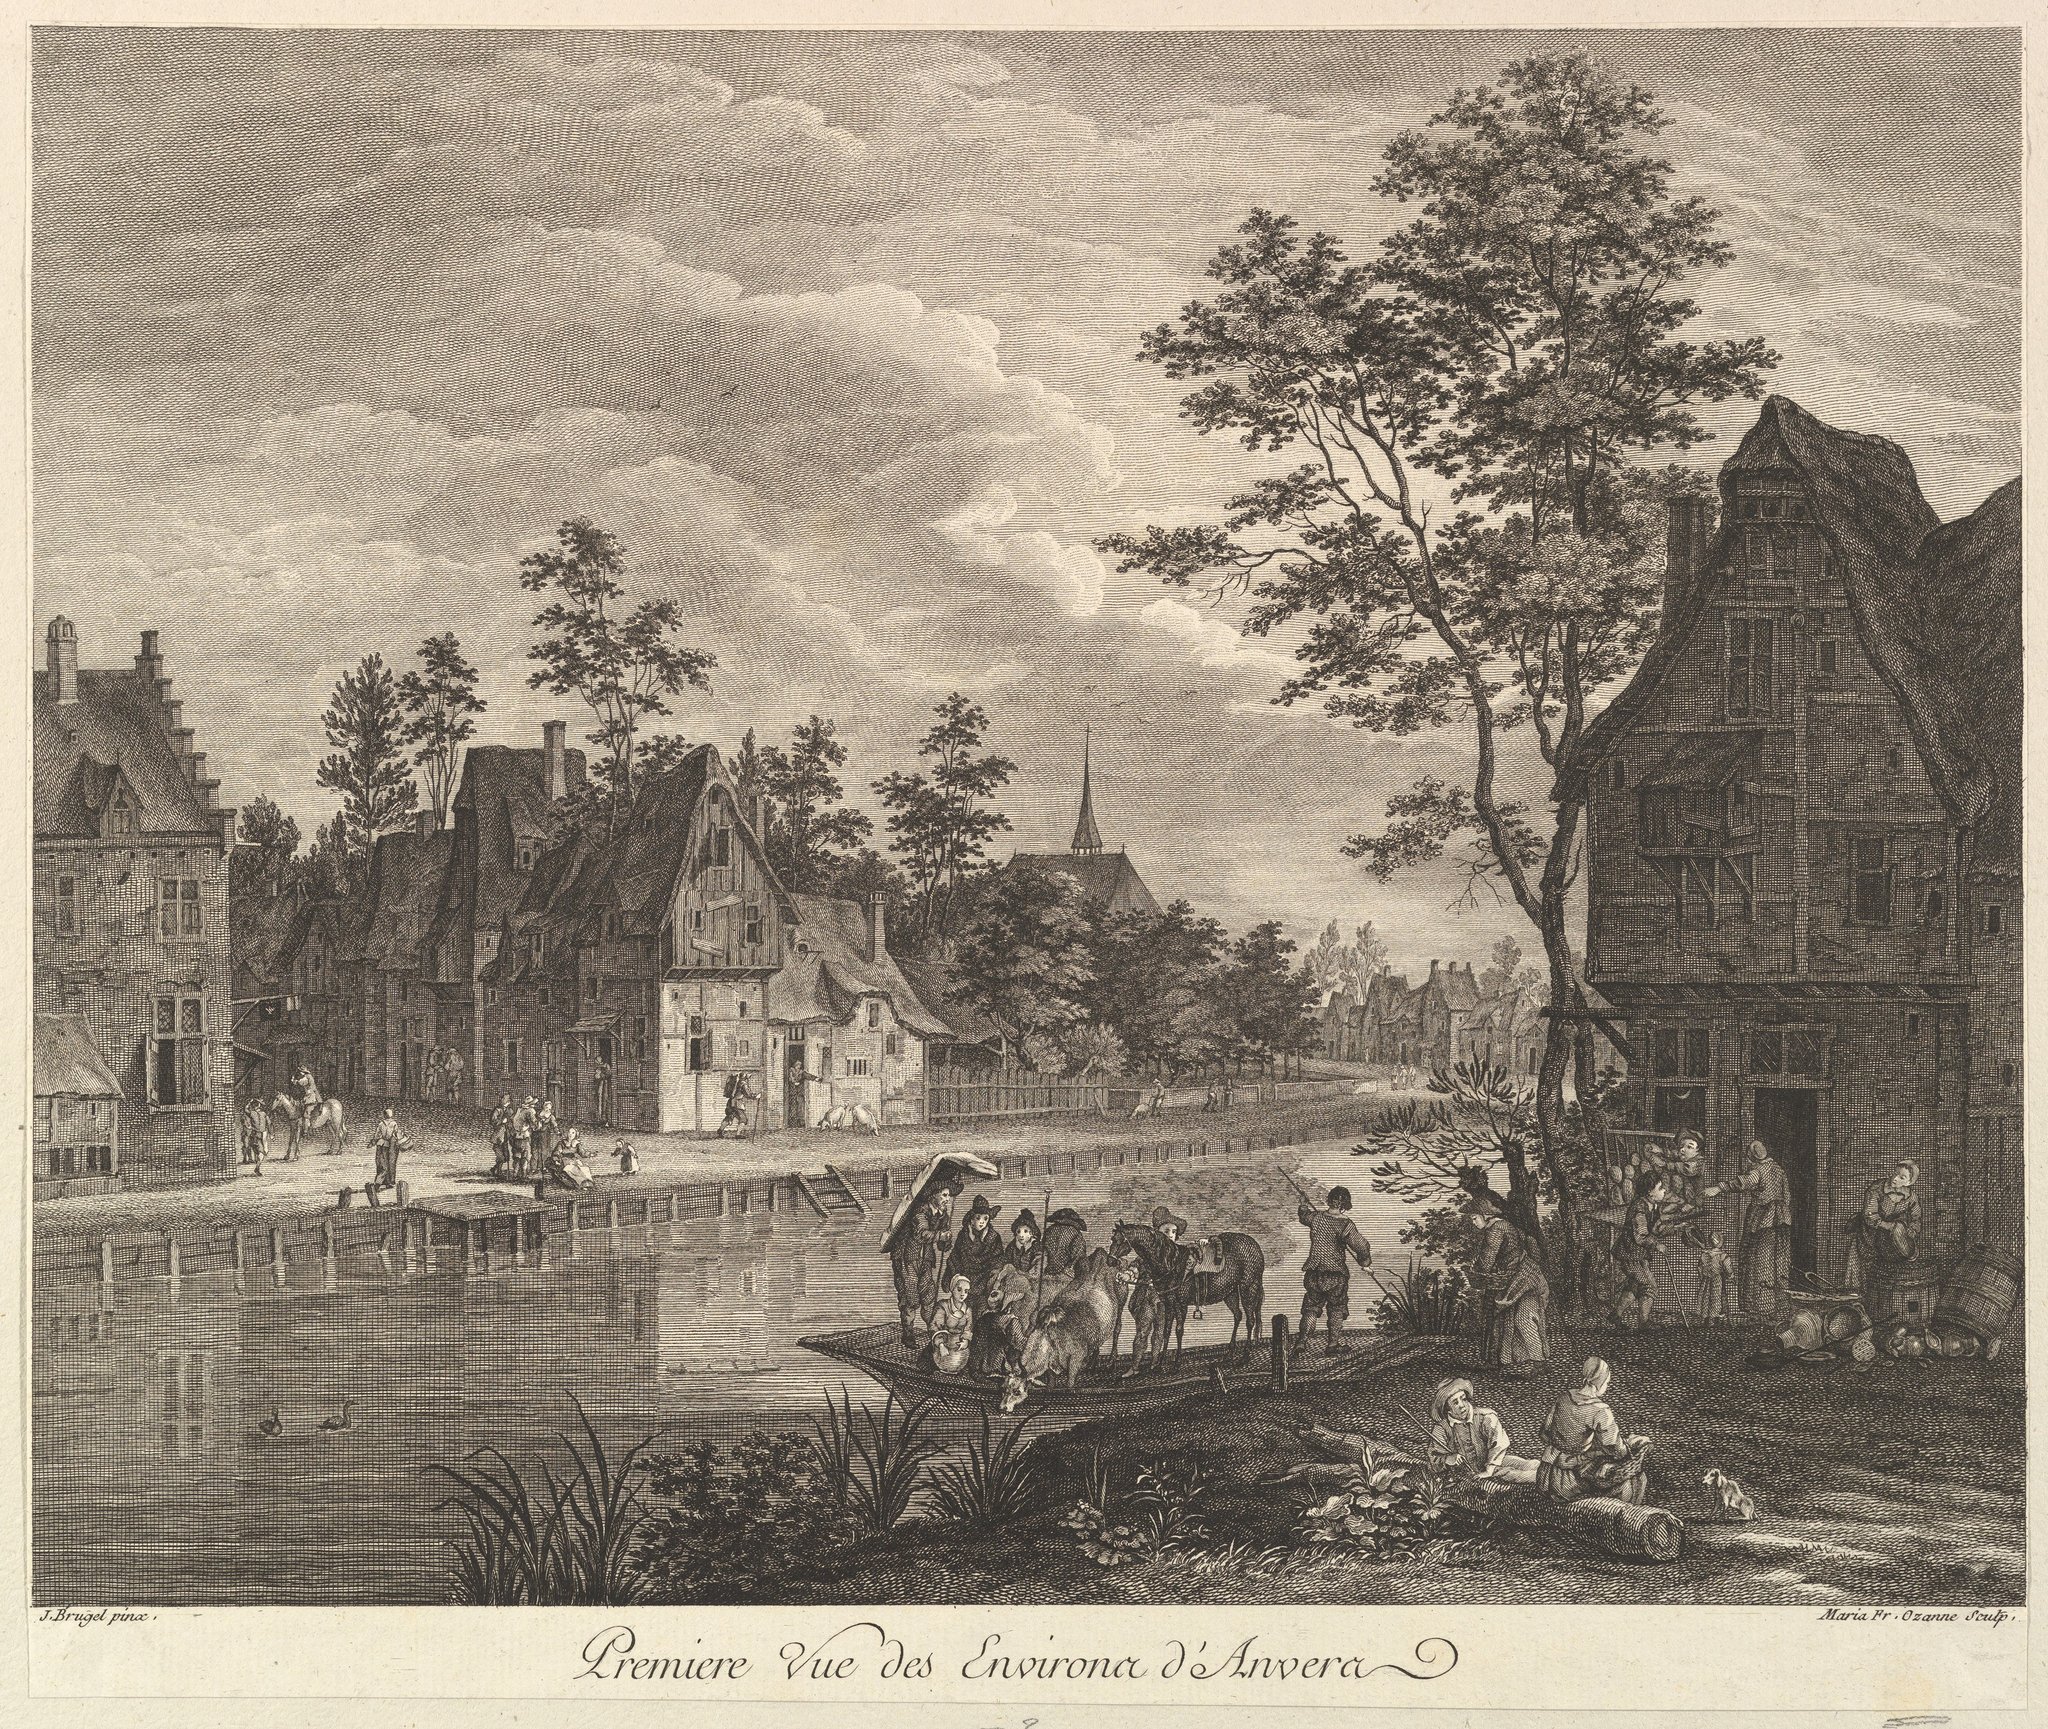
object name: print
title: First View of the Environs of Antwerp (Premiere Vue des Environs d'Anvers)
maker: maria fr. ozanne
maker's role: artist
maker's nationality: french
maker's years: 1700-1790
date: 1700-1790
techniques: engraving, etching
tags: human figures,houses,cows,horses,boats